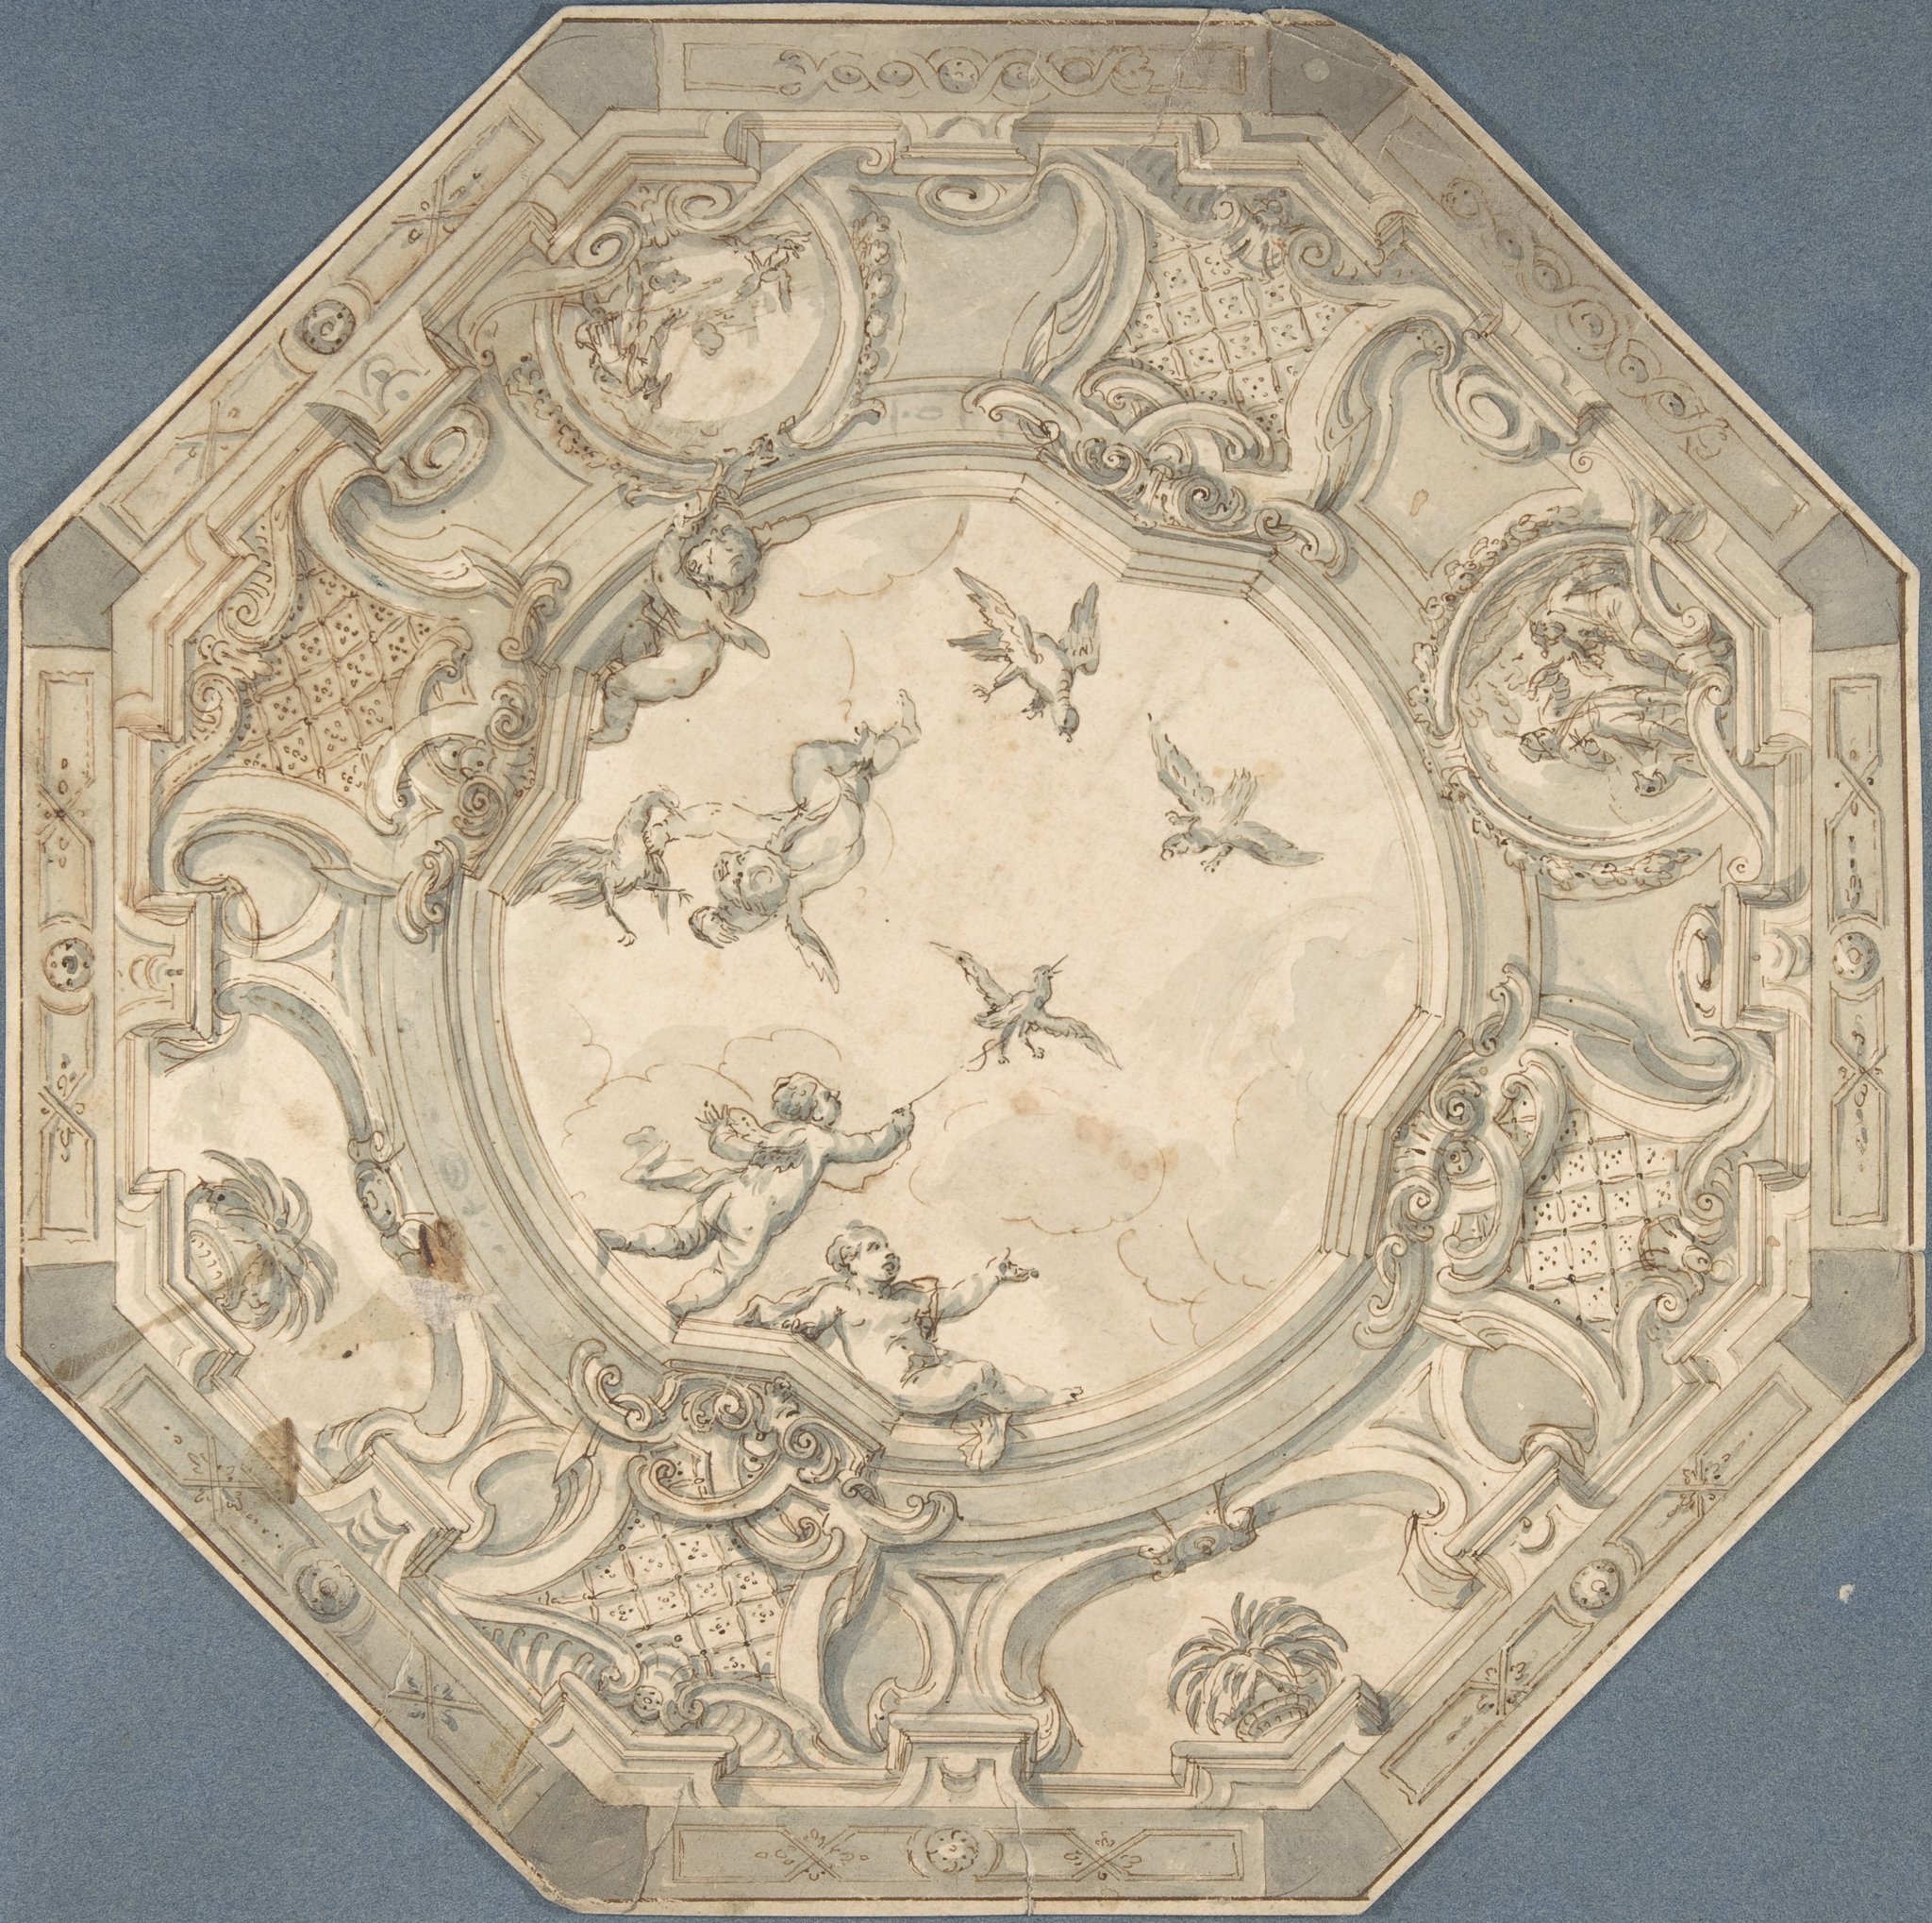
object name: drawing ornament architecture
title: Octagonal Ceiling Design with Putti and Birds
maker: anonymous, dutch, 18th century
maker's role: artist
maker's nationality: dutch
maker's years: 1700-1800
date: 1701-1800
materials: ink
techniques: brush, pen, wash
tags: birds,architecture,ornament,putti